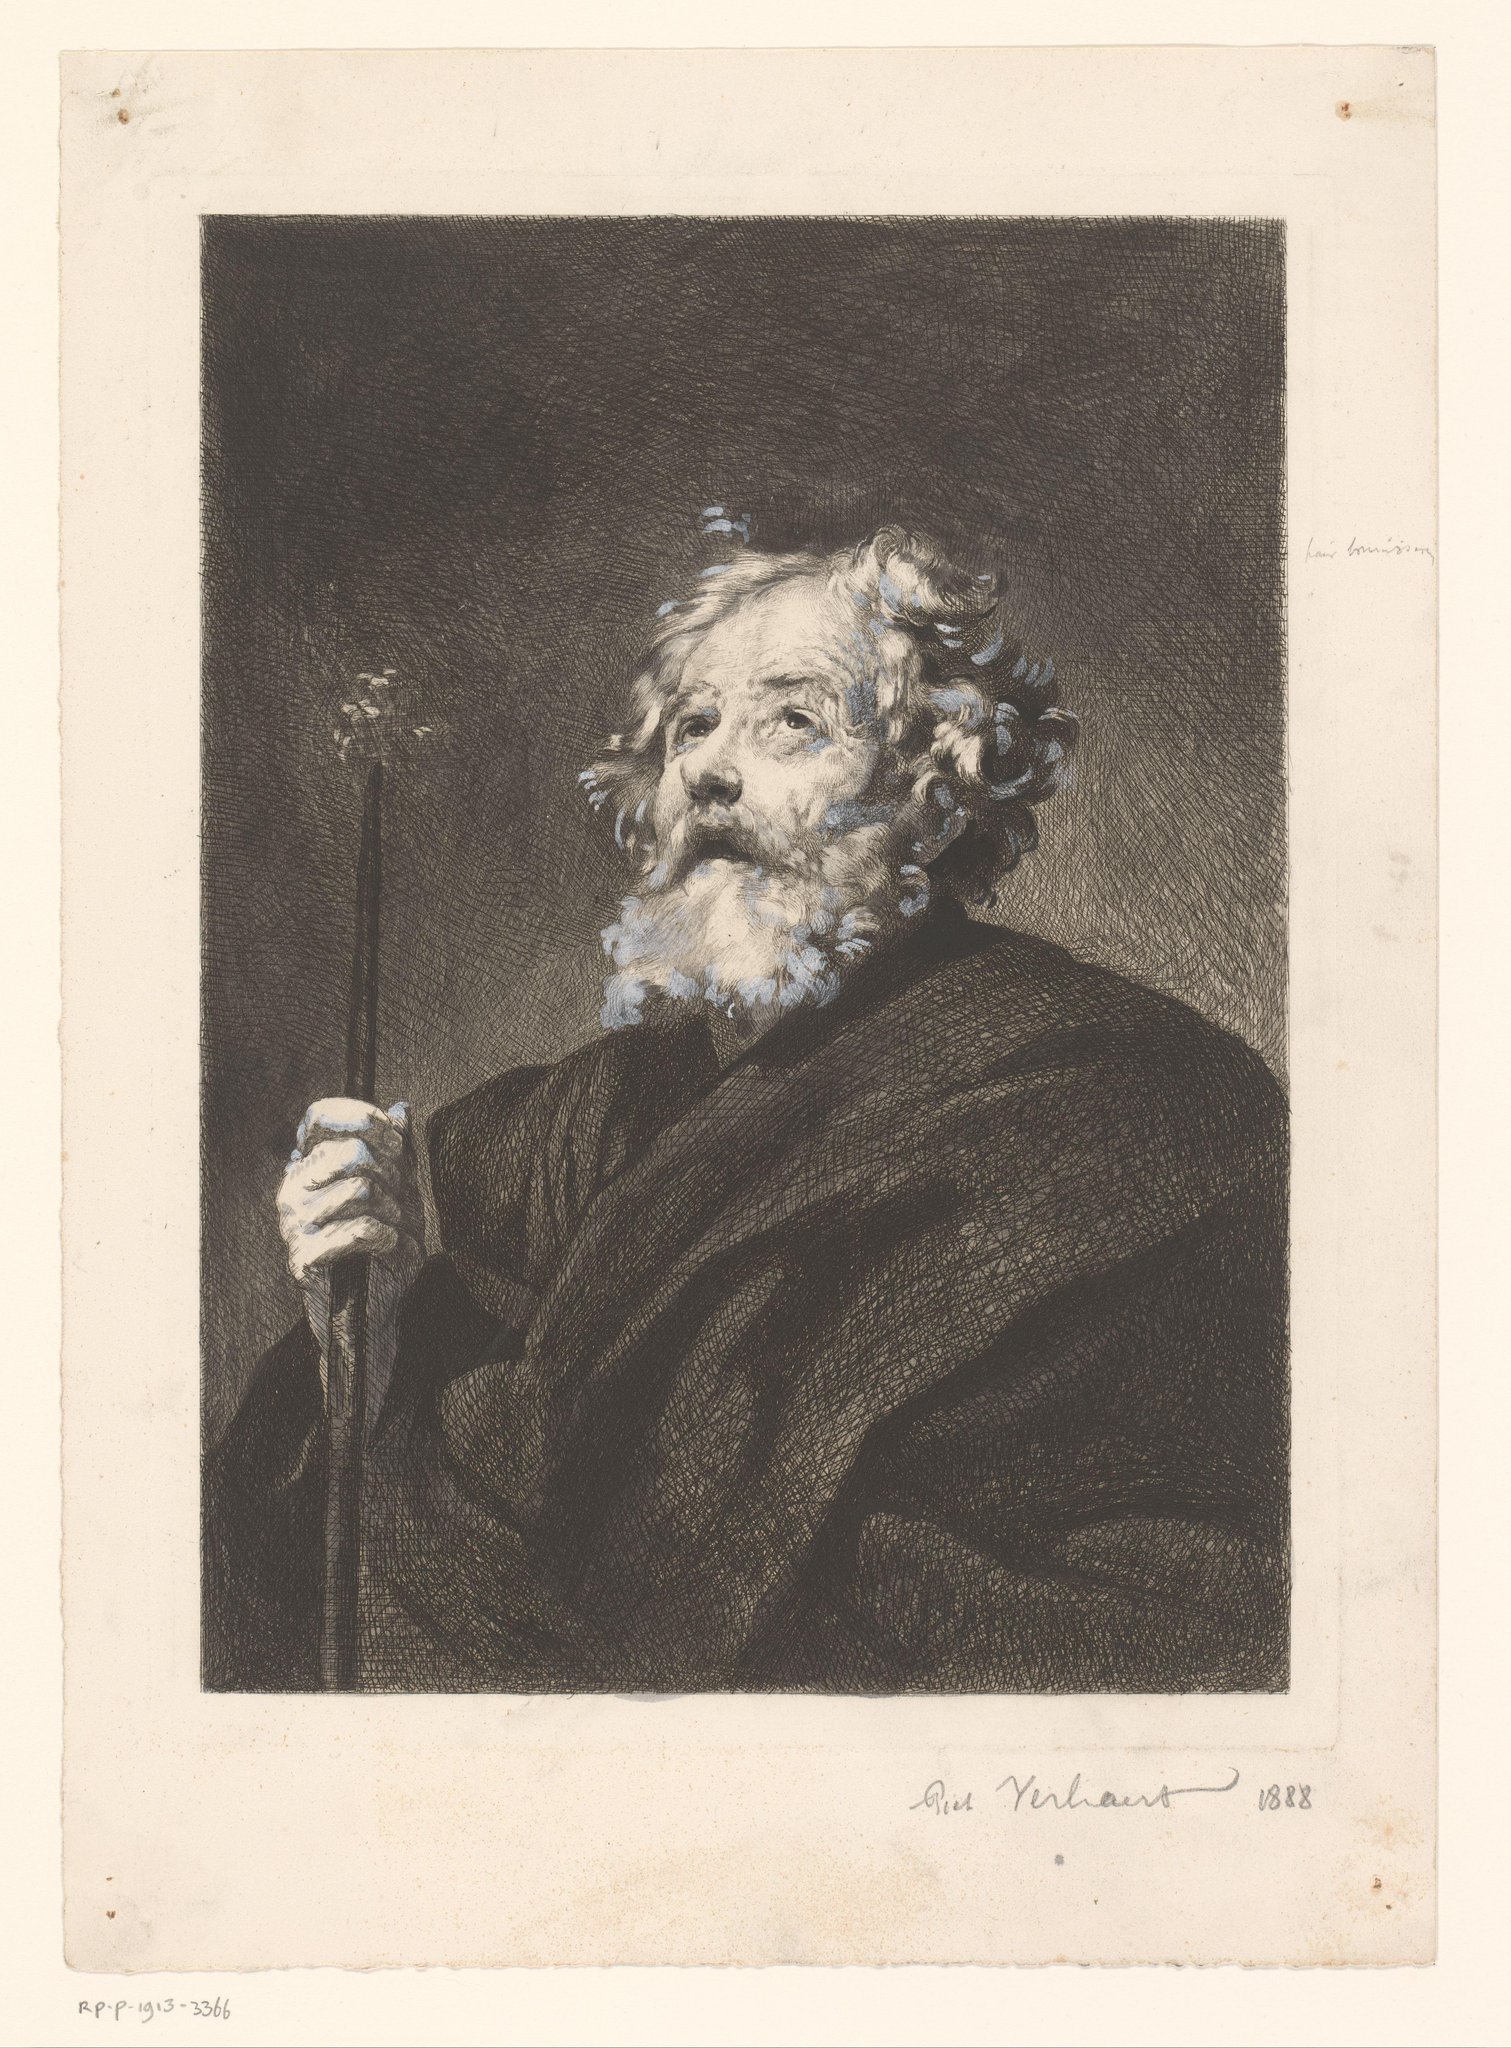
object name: print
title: Heilige Jozef met staf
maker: piet verhaert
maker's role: print maker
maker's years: 1852-1908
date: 1888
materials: paint, paper, watercolor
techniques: brush, etching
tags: the foster-father of christ, joseph of nazareth, husband of mary; possible attributes: flowering rod or wand, lily, carpenter's tools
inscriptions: collector's mark: Lugt 2228